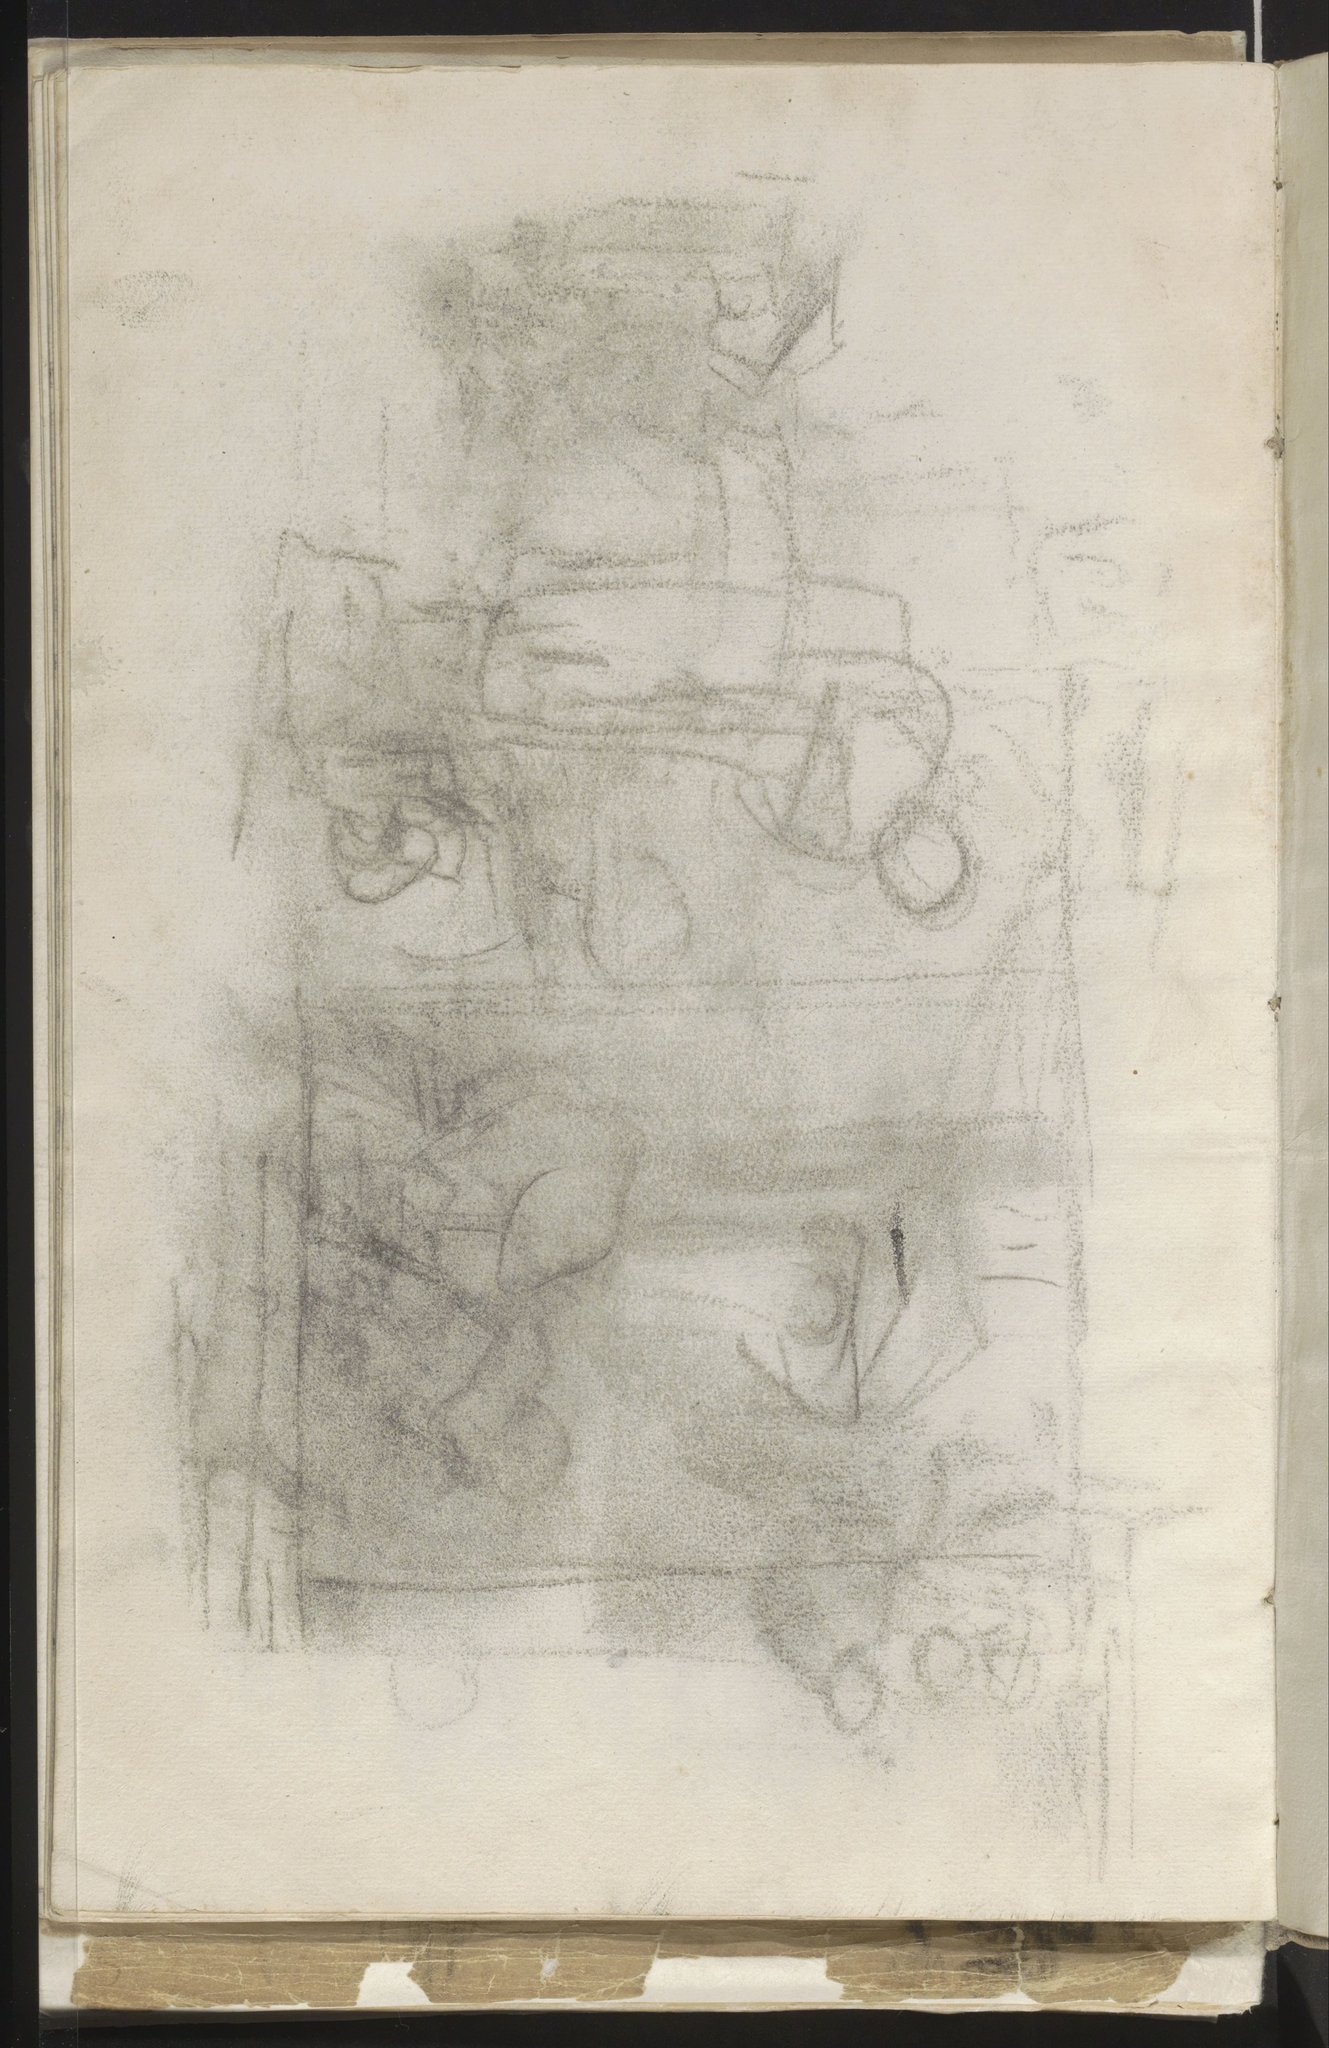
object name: sketchbook leaf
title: Studie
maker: albert neuhuys (1844-1914)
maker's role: draughtsman, painter, print maker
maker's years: 1844-1914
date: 1854-1914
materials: charcoal, paper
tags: anatomy (non-medical)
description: Blad 48 verso uit een schetsboek met 53 bladen.